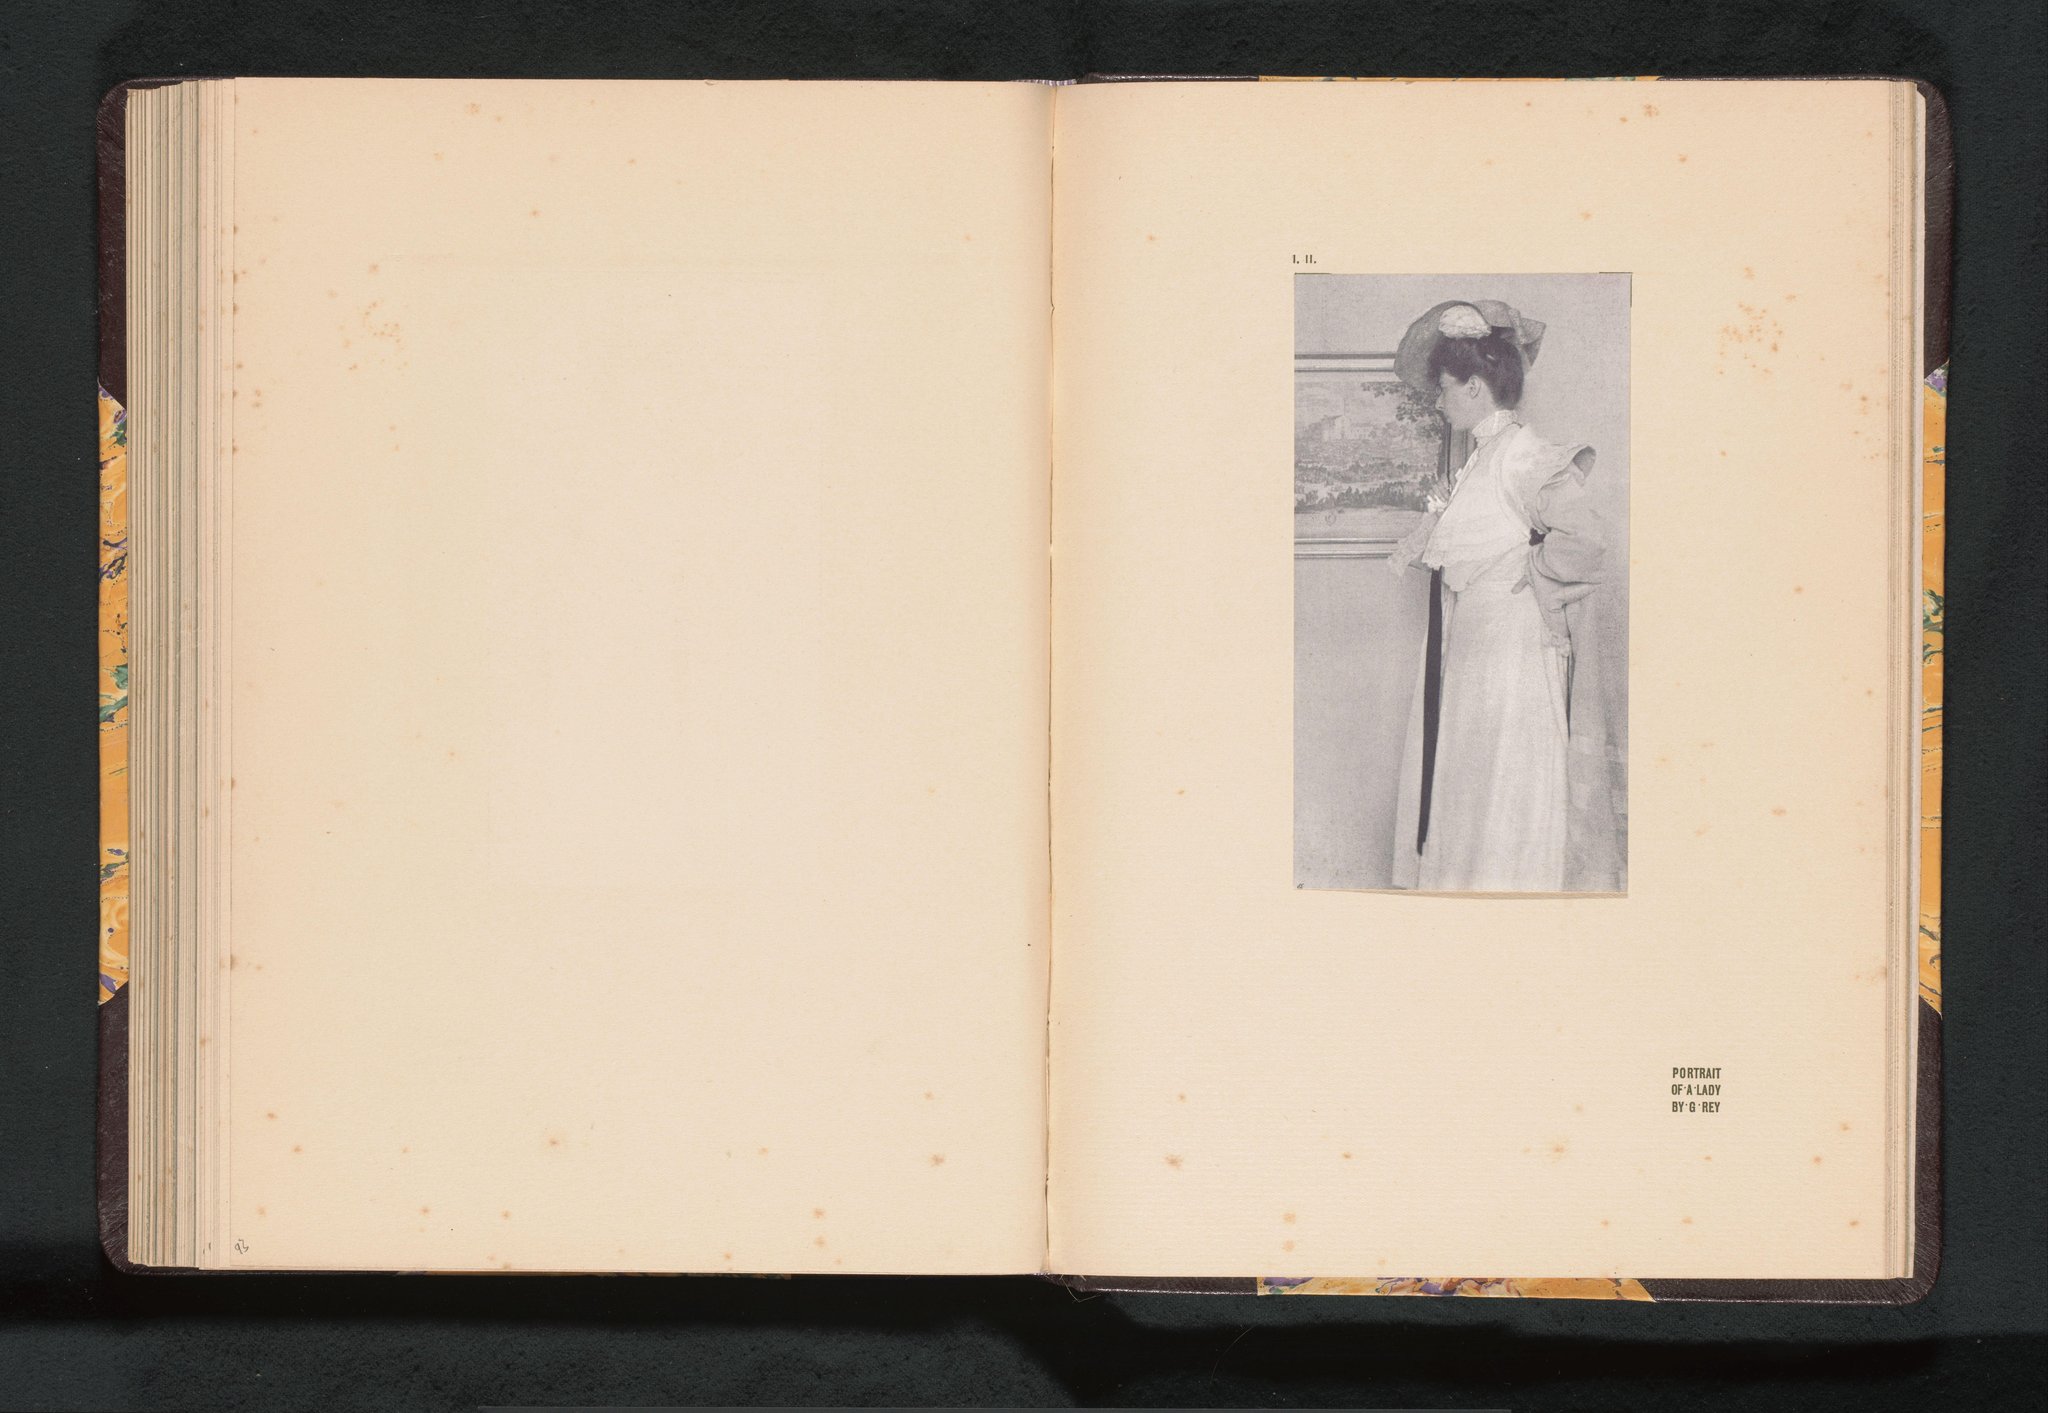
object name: page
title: Profiel van een onbekende vrouw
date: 1900-1905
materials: paper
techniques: autotype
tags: adult woman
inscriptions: inscription: ‘I. II.’, inscription: ‘Portrait of a lady by G. Rey’, monogram: ‘AG’